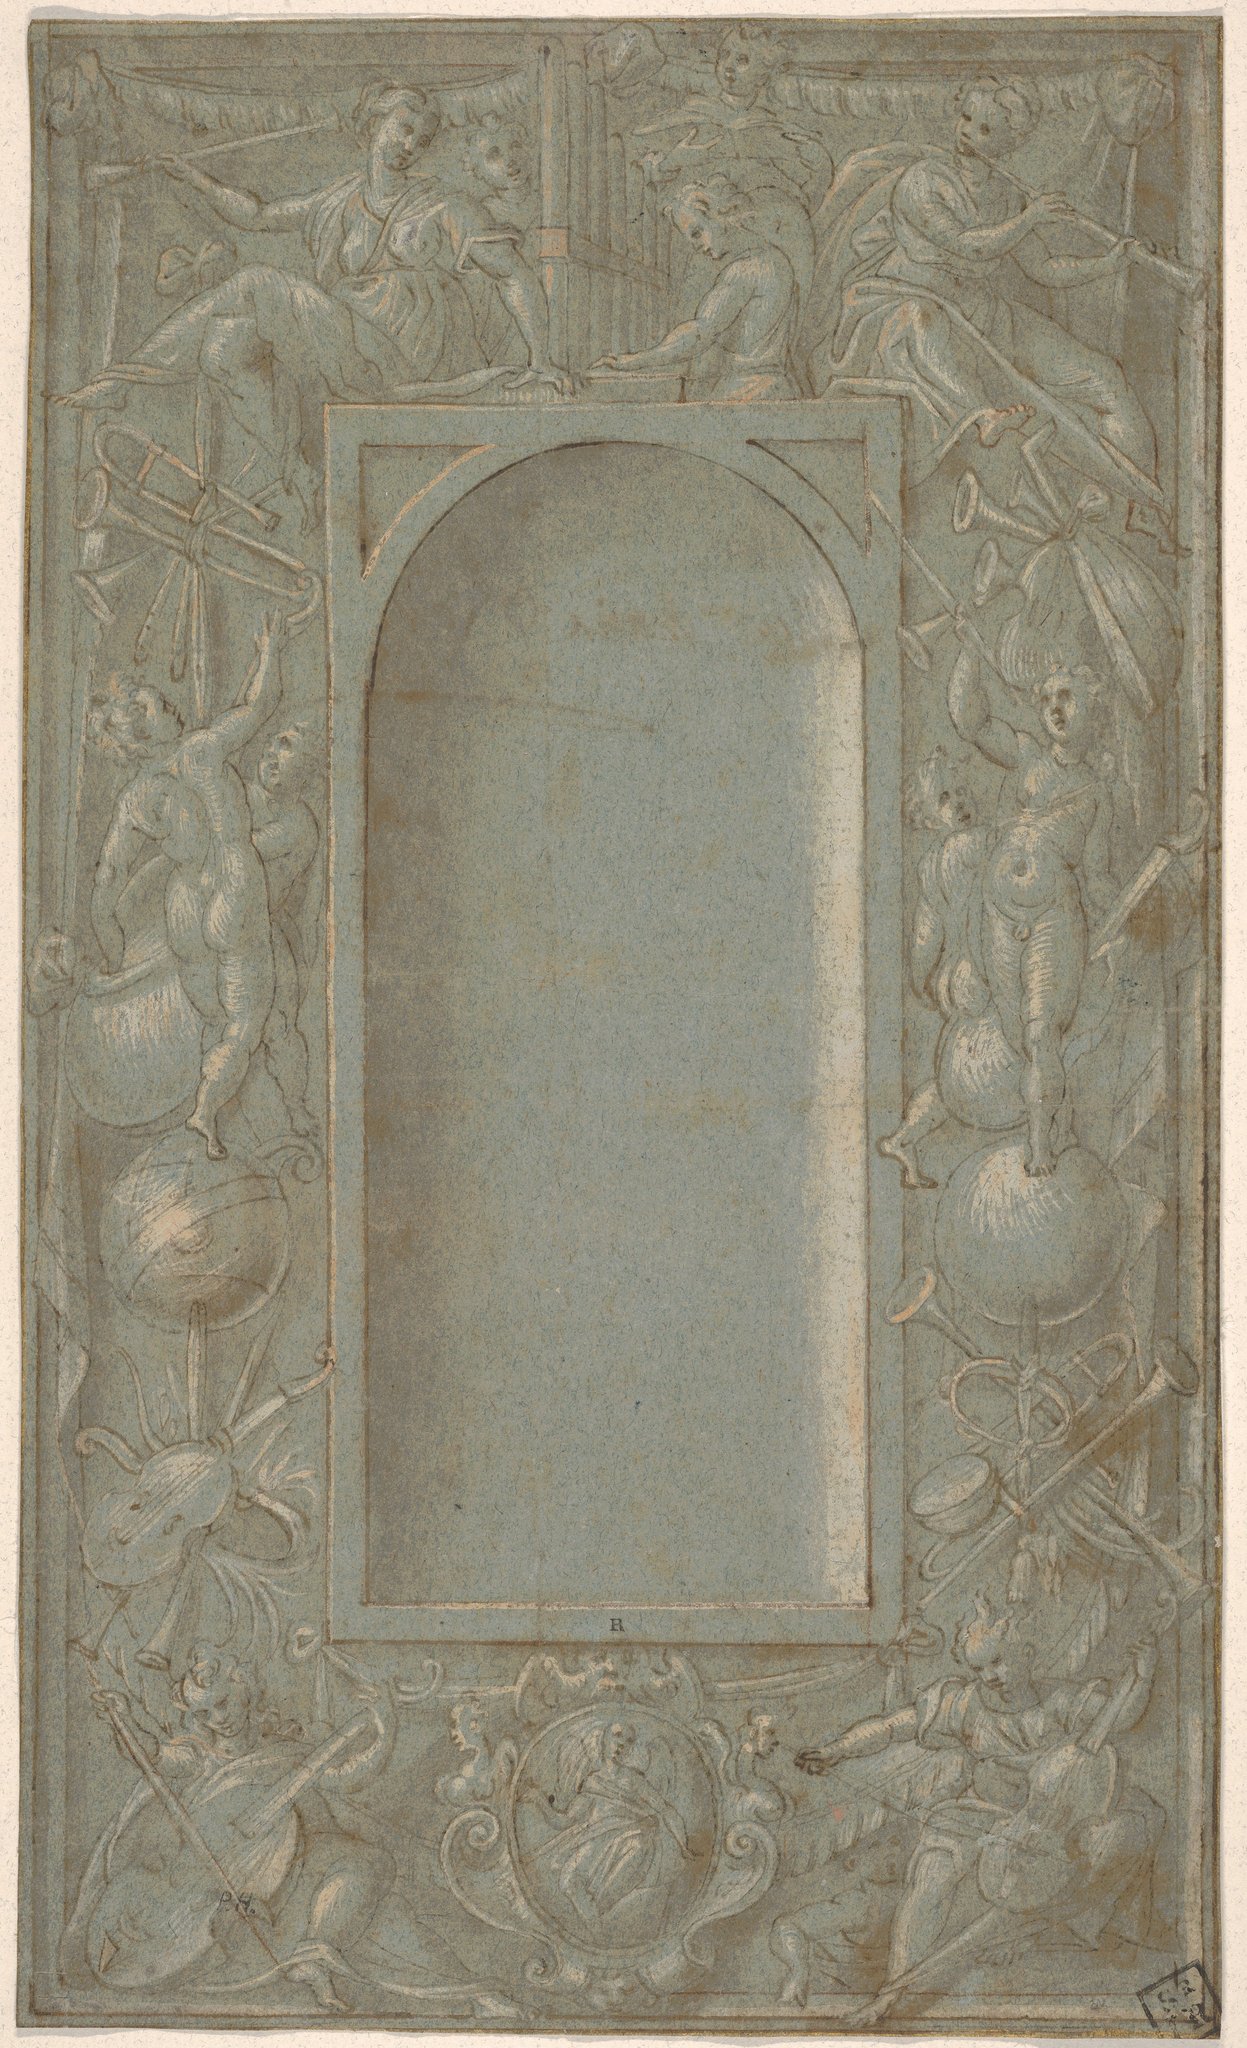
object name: drawing ornament architecture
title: Niche Surrounded by a Decorative Frame Dedicated to the Theme of Music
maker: anonymous, italian, lombard, 16th century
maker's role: artist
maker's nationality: italian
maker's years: 1500-1600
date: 1540-1570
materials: gold, ink, paper, silver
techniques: brush, heightening, pen, wash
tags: male nudes,women,trumpets,violins